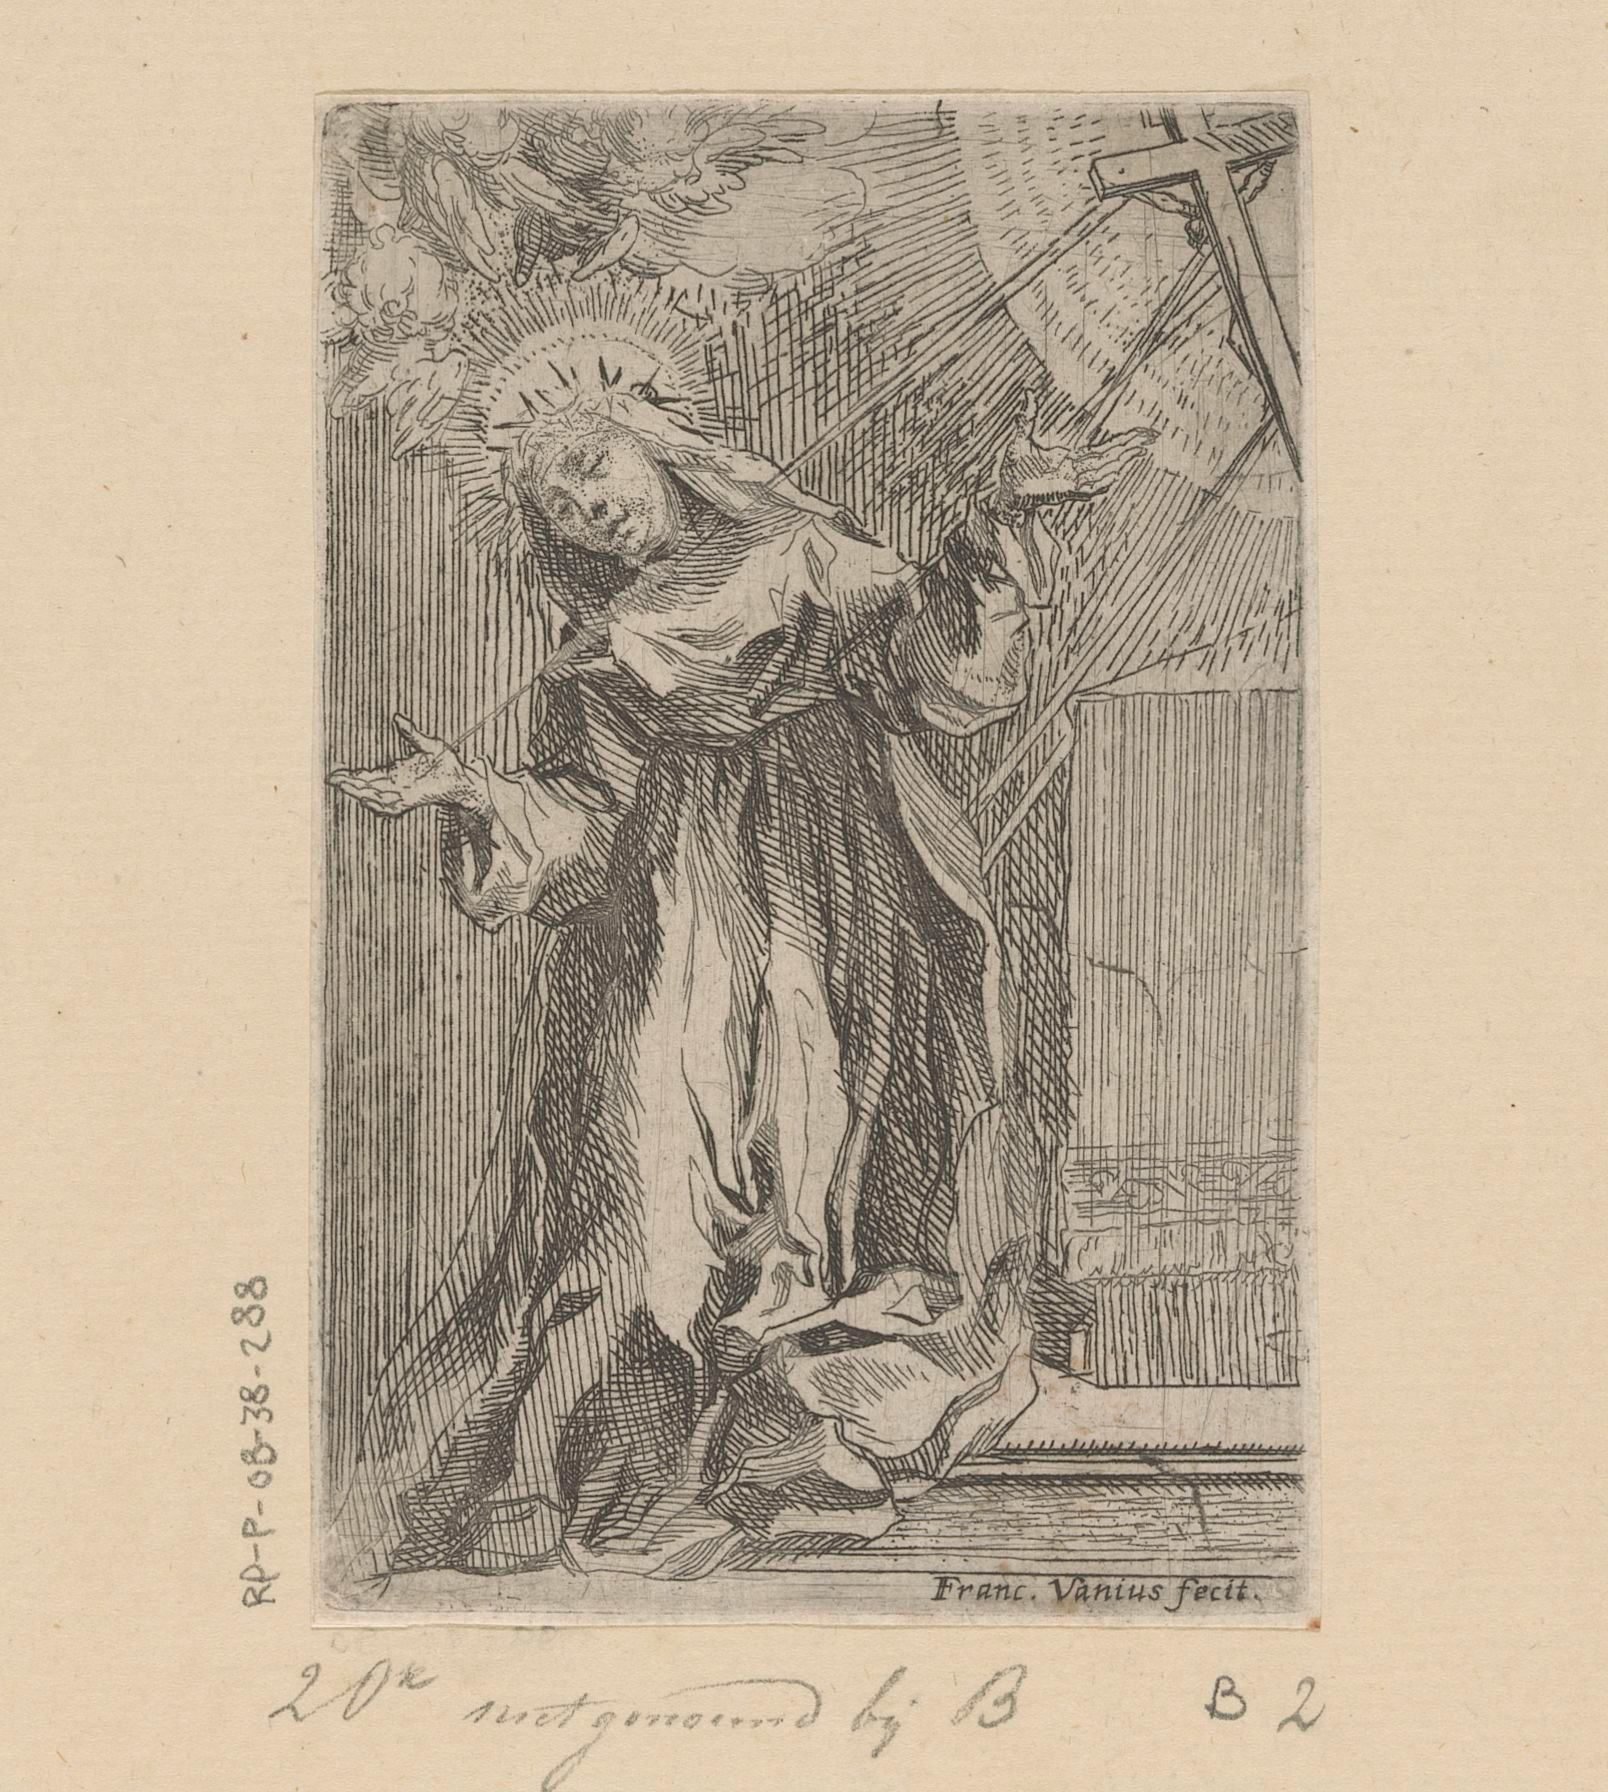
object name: print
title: Heilige Catharina van Siena ontvangt de stigmata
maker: francesco vanni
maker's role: draughtsman, print maker, publisher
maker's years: 1563-1610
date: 1573-1610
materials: paper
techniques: etching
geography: italy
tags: cherubs, i.e. children's heads with wings, st. catherine of siena, kneeling before a crucifix, or swooning into the arms of two nuns, receives the stigmata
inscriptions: collector's mark: Lugt 240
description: De heilige Catharina van Siena, knielend voor een crucifix, ontvangt de stigmata. Linksboven cherubijnen.